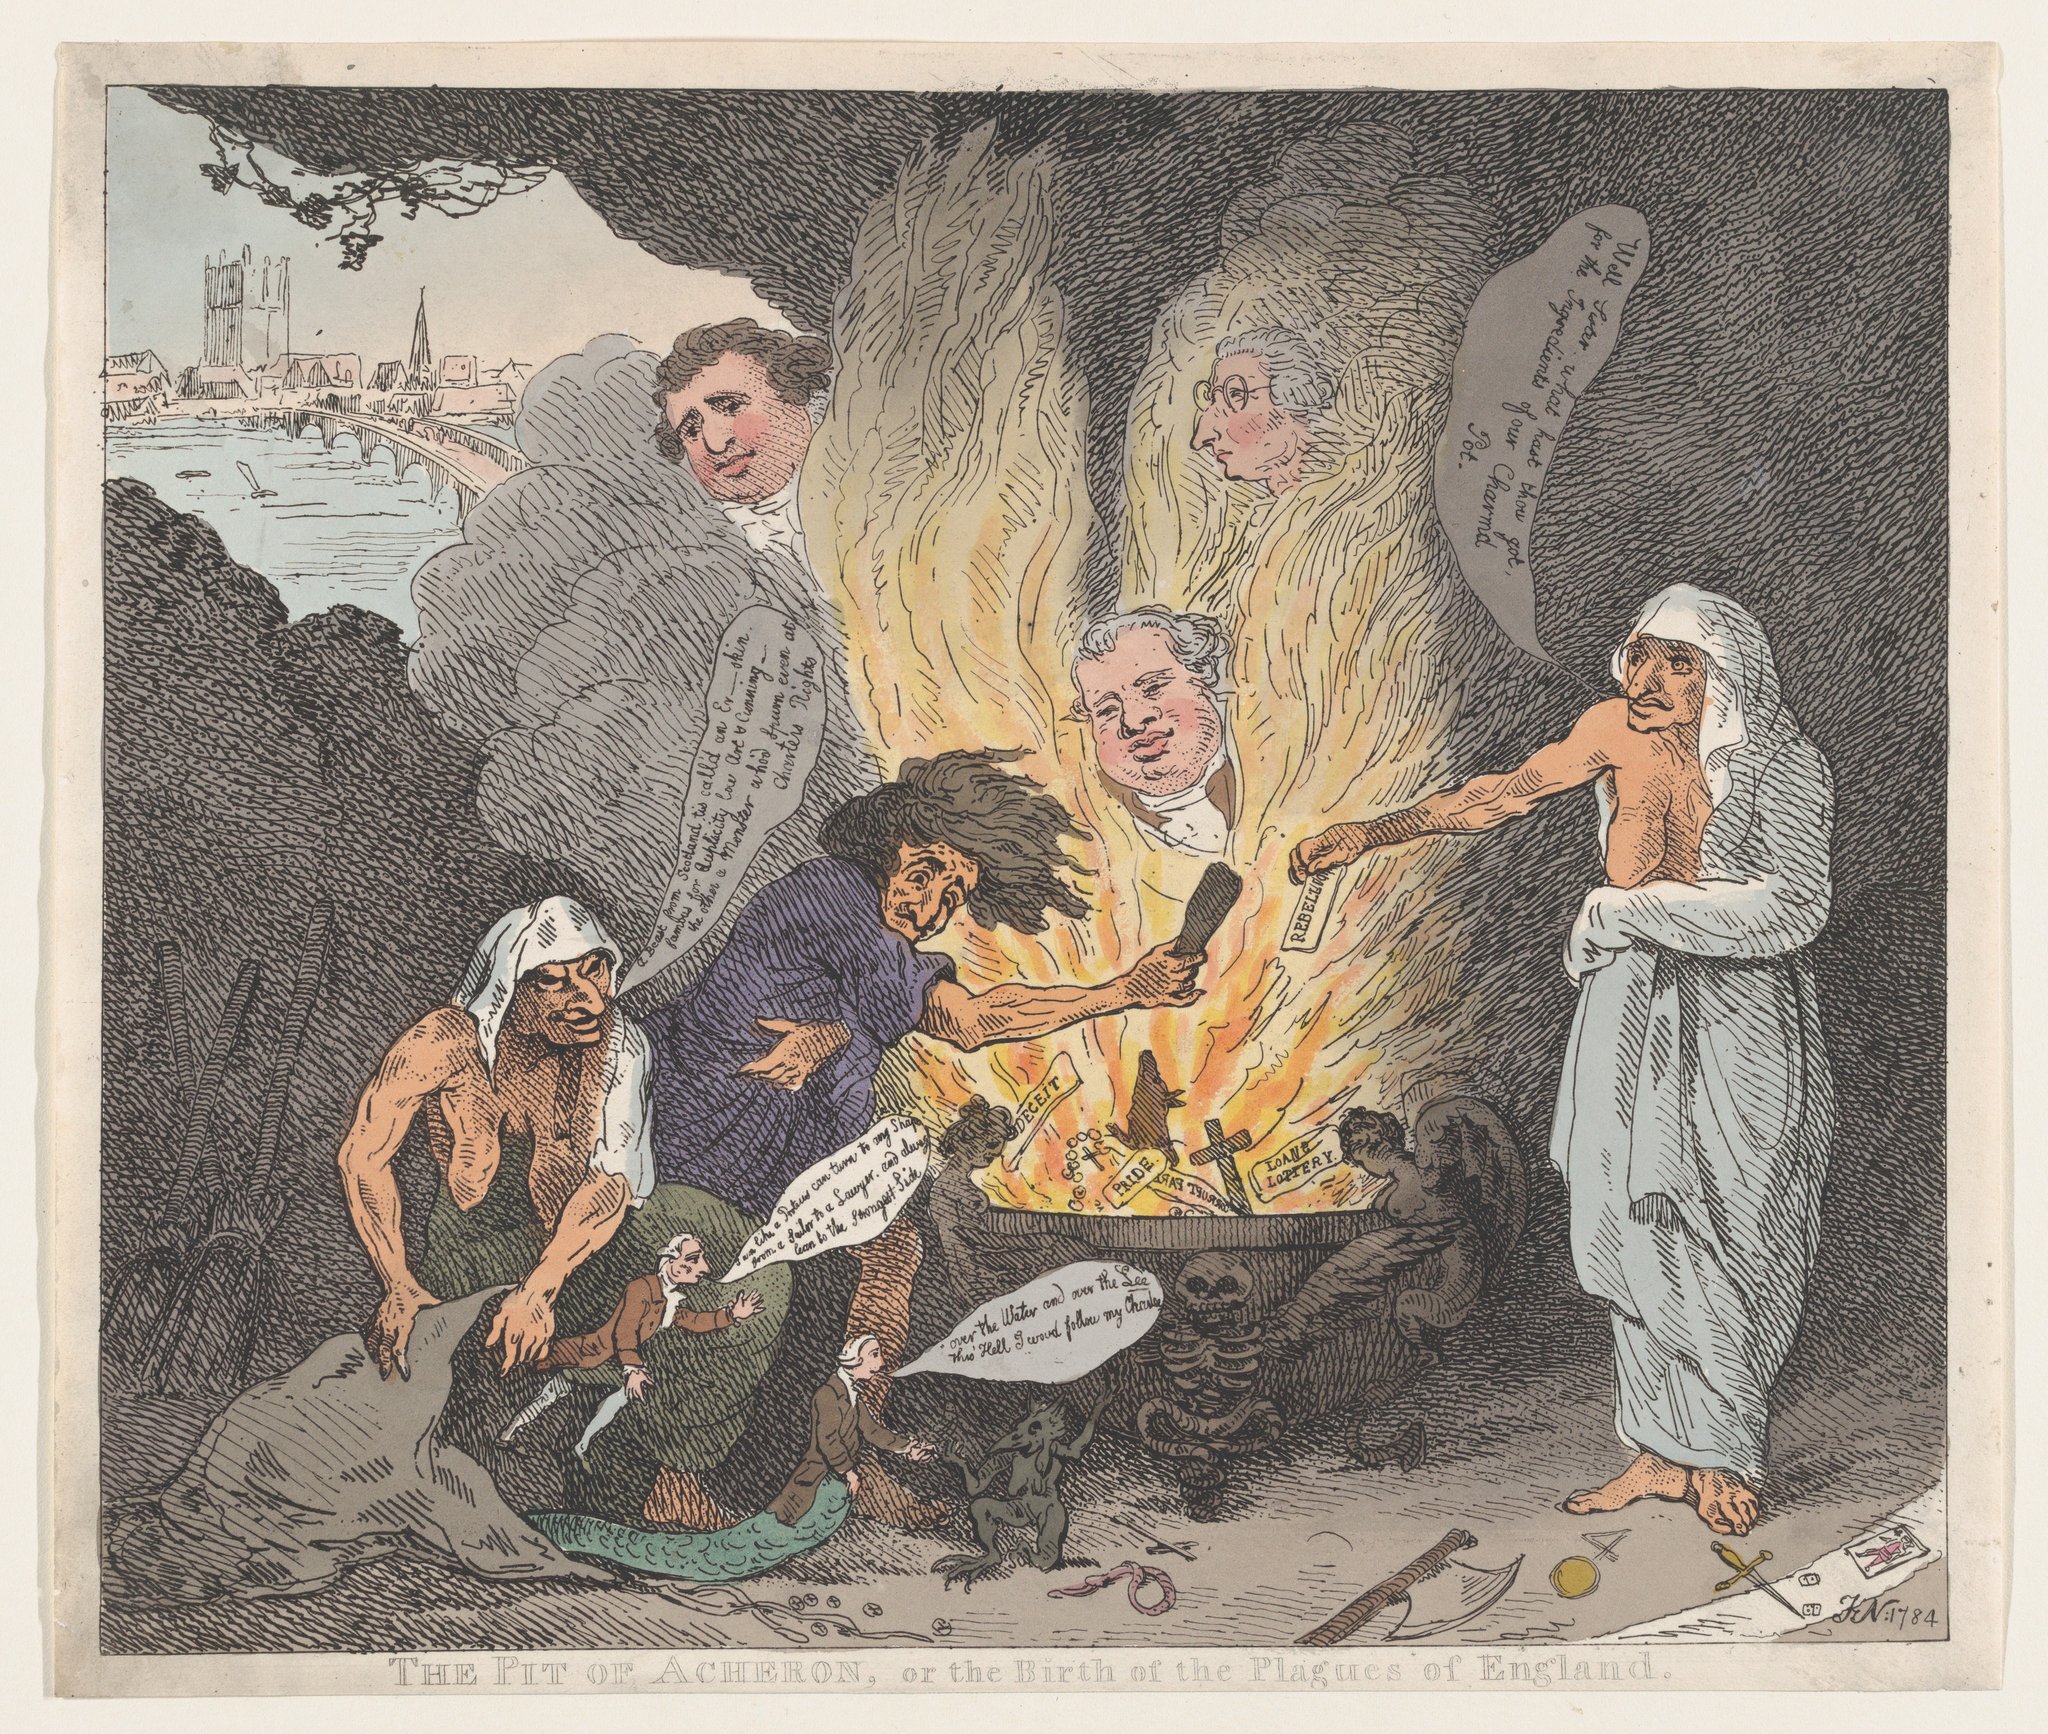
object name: print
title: The Pit of Acheron or The Birth of the Plagues of England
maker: thomas rowlandson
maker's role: artist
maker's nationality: british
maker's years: 1757-1827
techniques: etching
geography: london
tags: satire,men,women,fire,politics